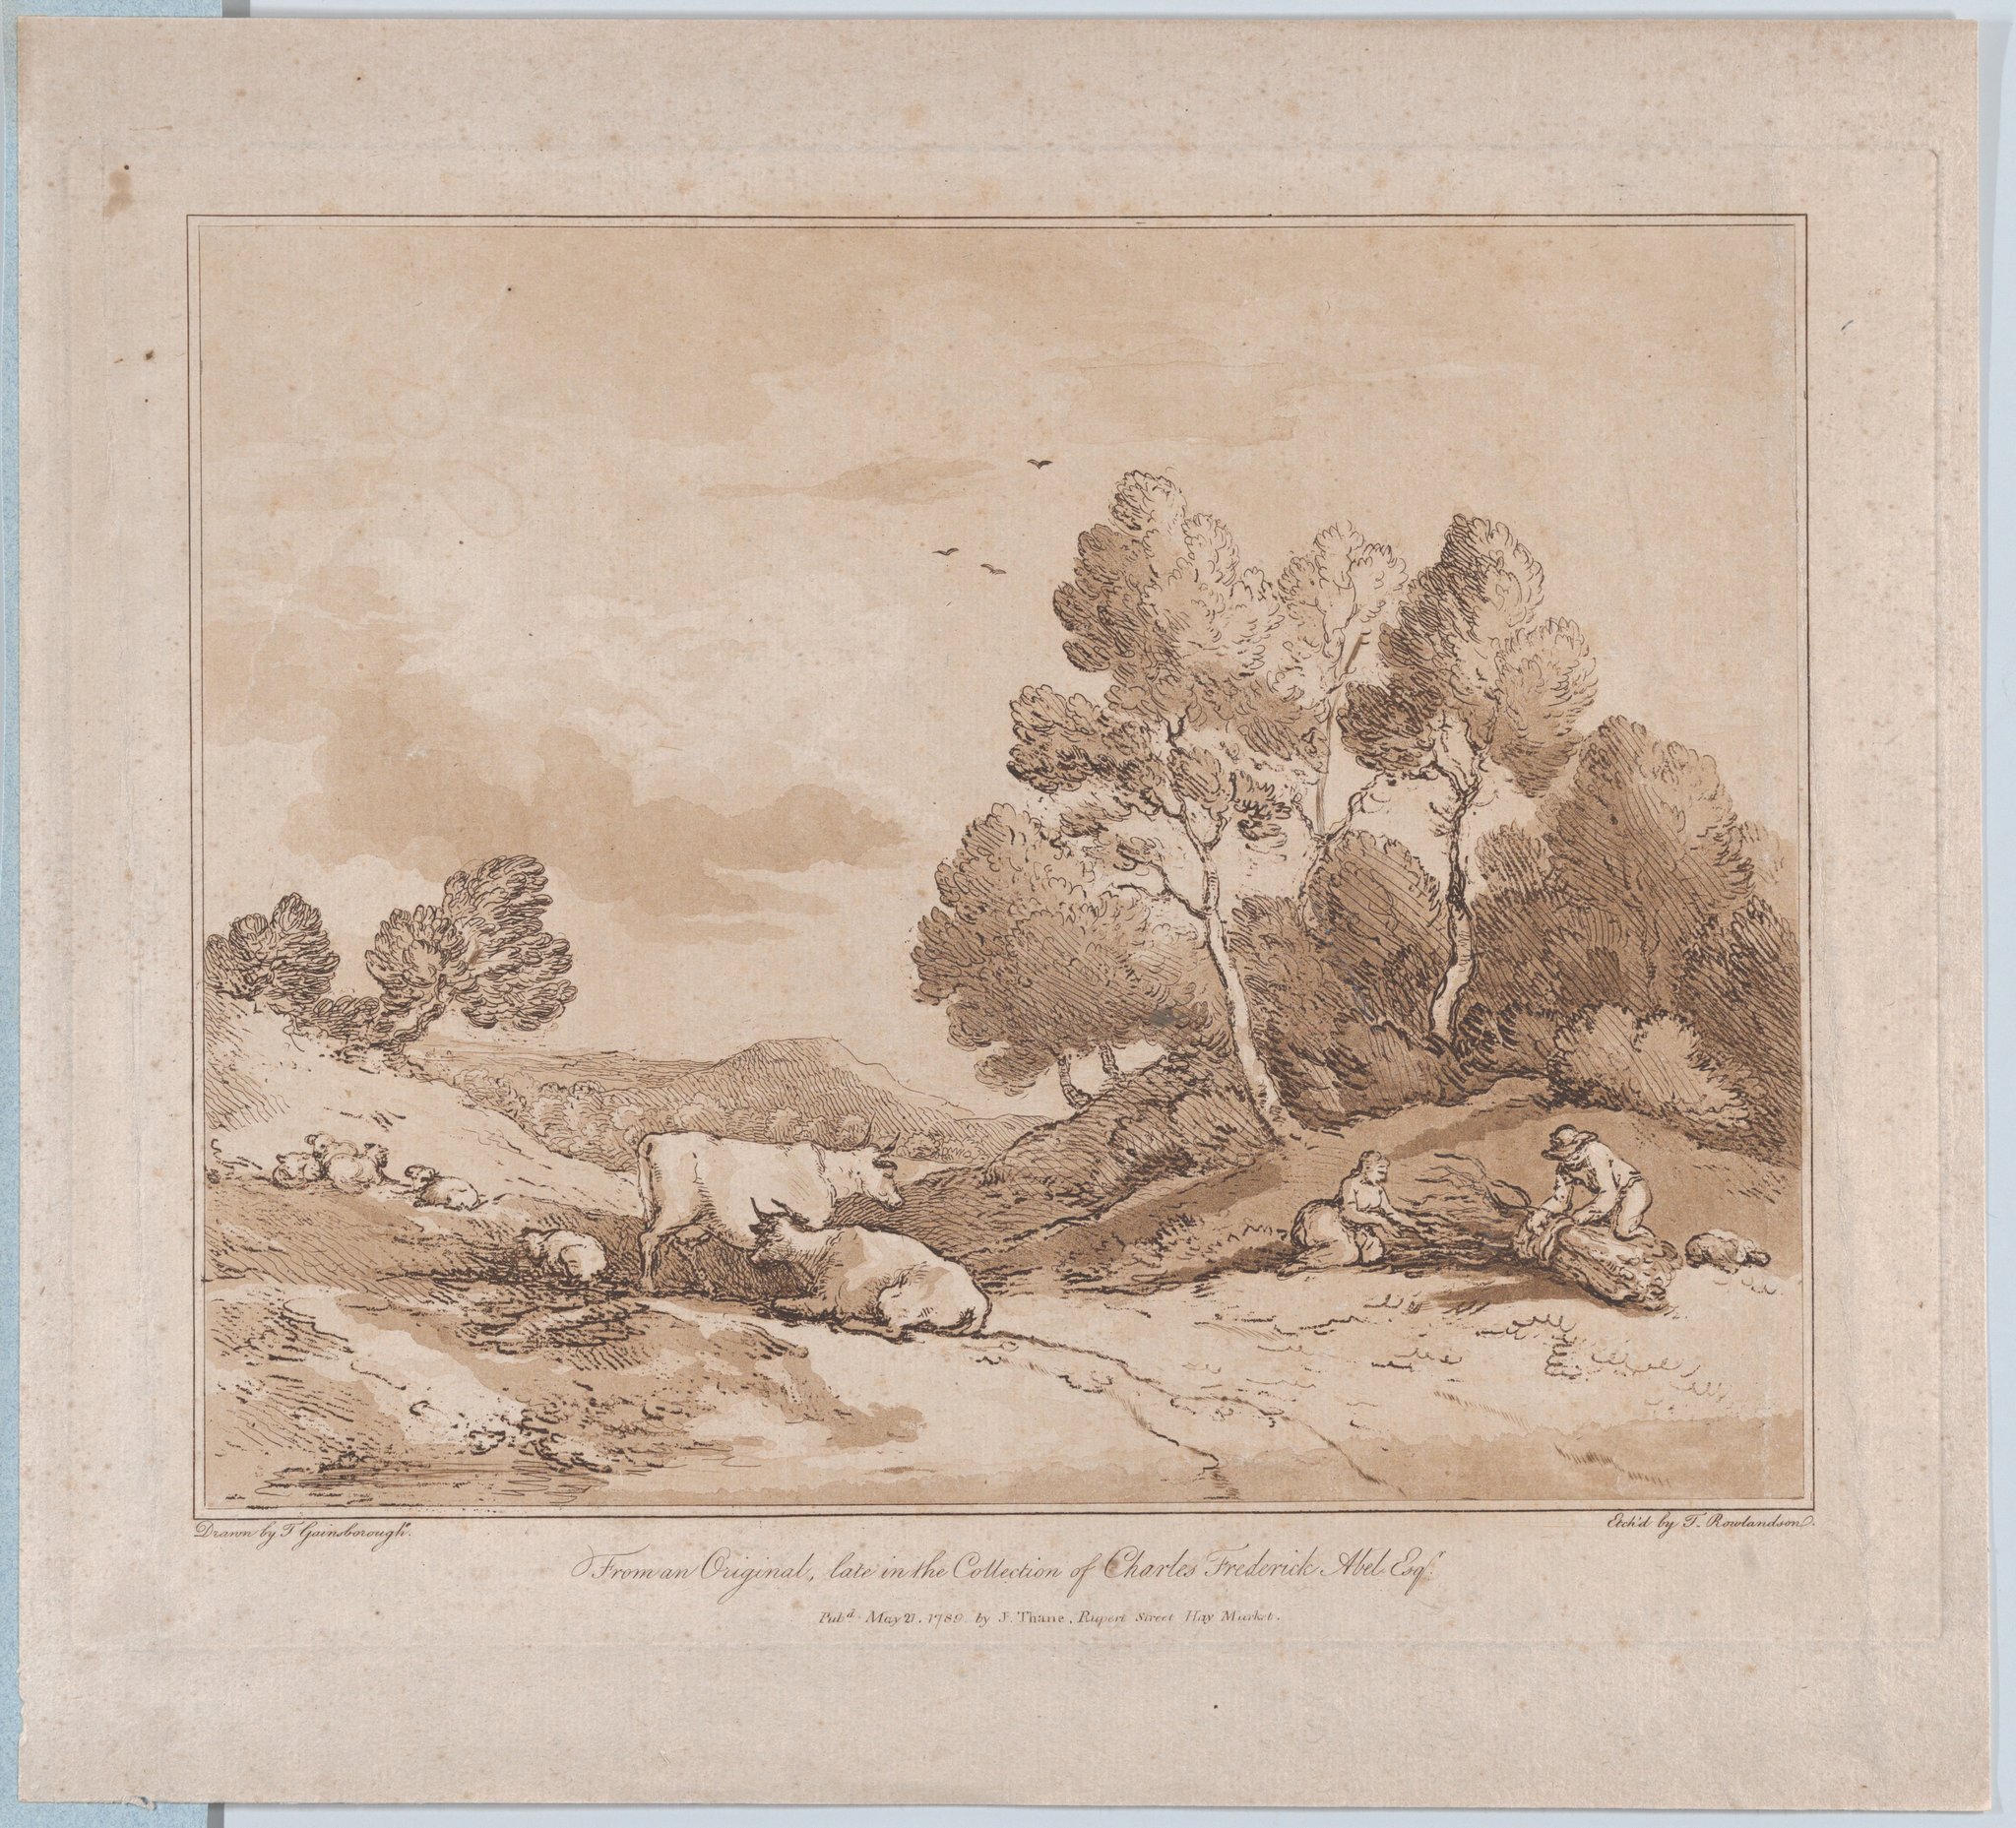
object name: print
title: Landscape with Figures Binding a Bundle of Wood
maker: thomas rowlandson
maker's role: artist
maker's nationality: british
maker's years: 1757-1827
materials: ink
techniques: aquatint, etching, printing